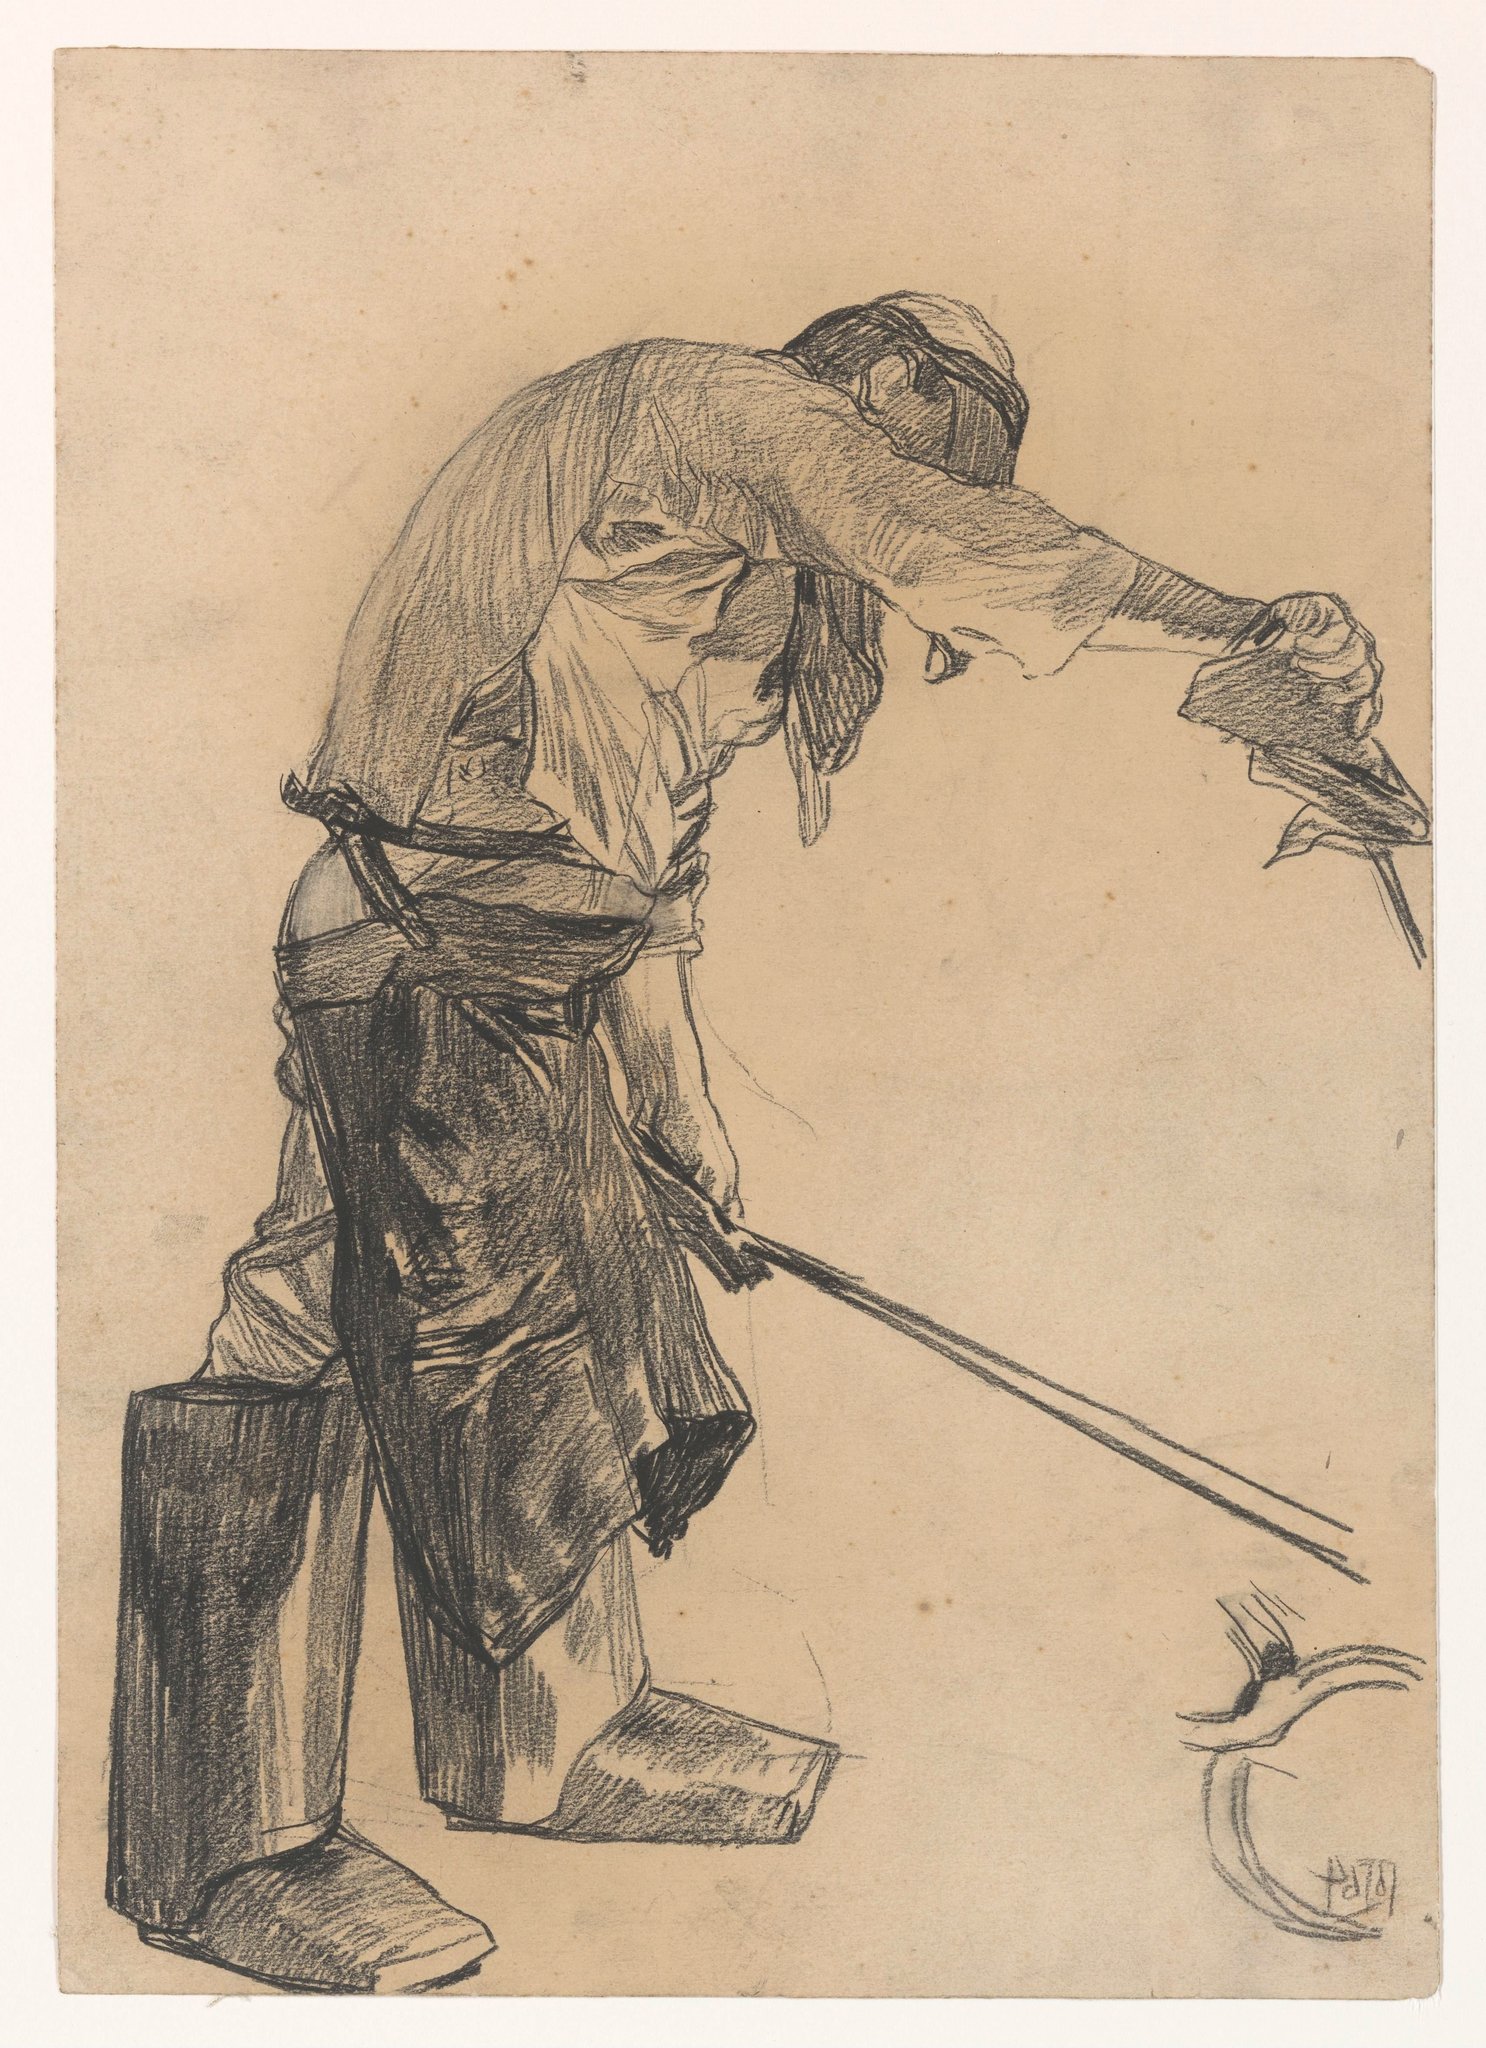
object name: drawing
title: Arbeider in staalfabriek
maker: pieter de josselin de jong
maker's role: draughtsman, painter, print maker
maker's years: 1861-1906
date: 1871-1906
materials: chalk, paper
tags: iron and steel industry (+ men (labourers))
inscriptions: inscription: ‘146 / Mokeraar’